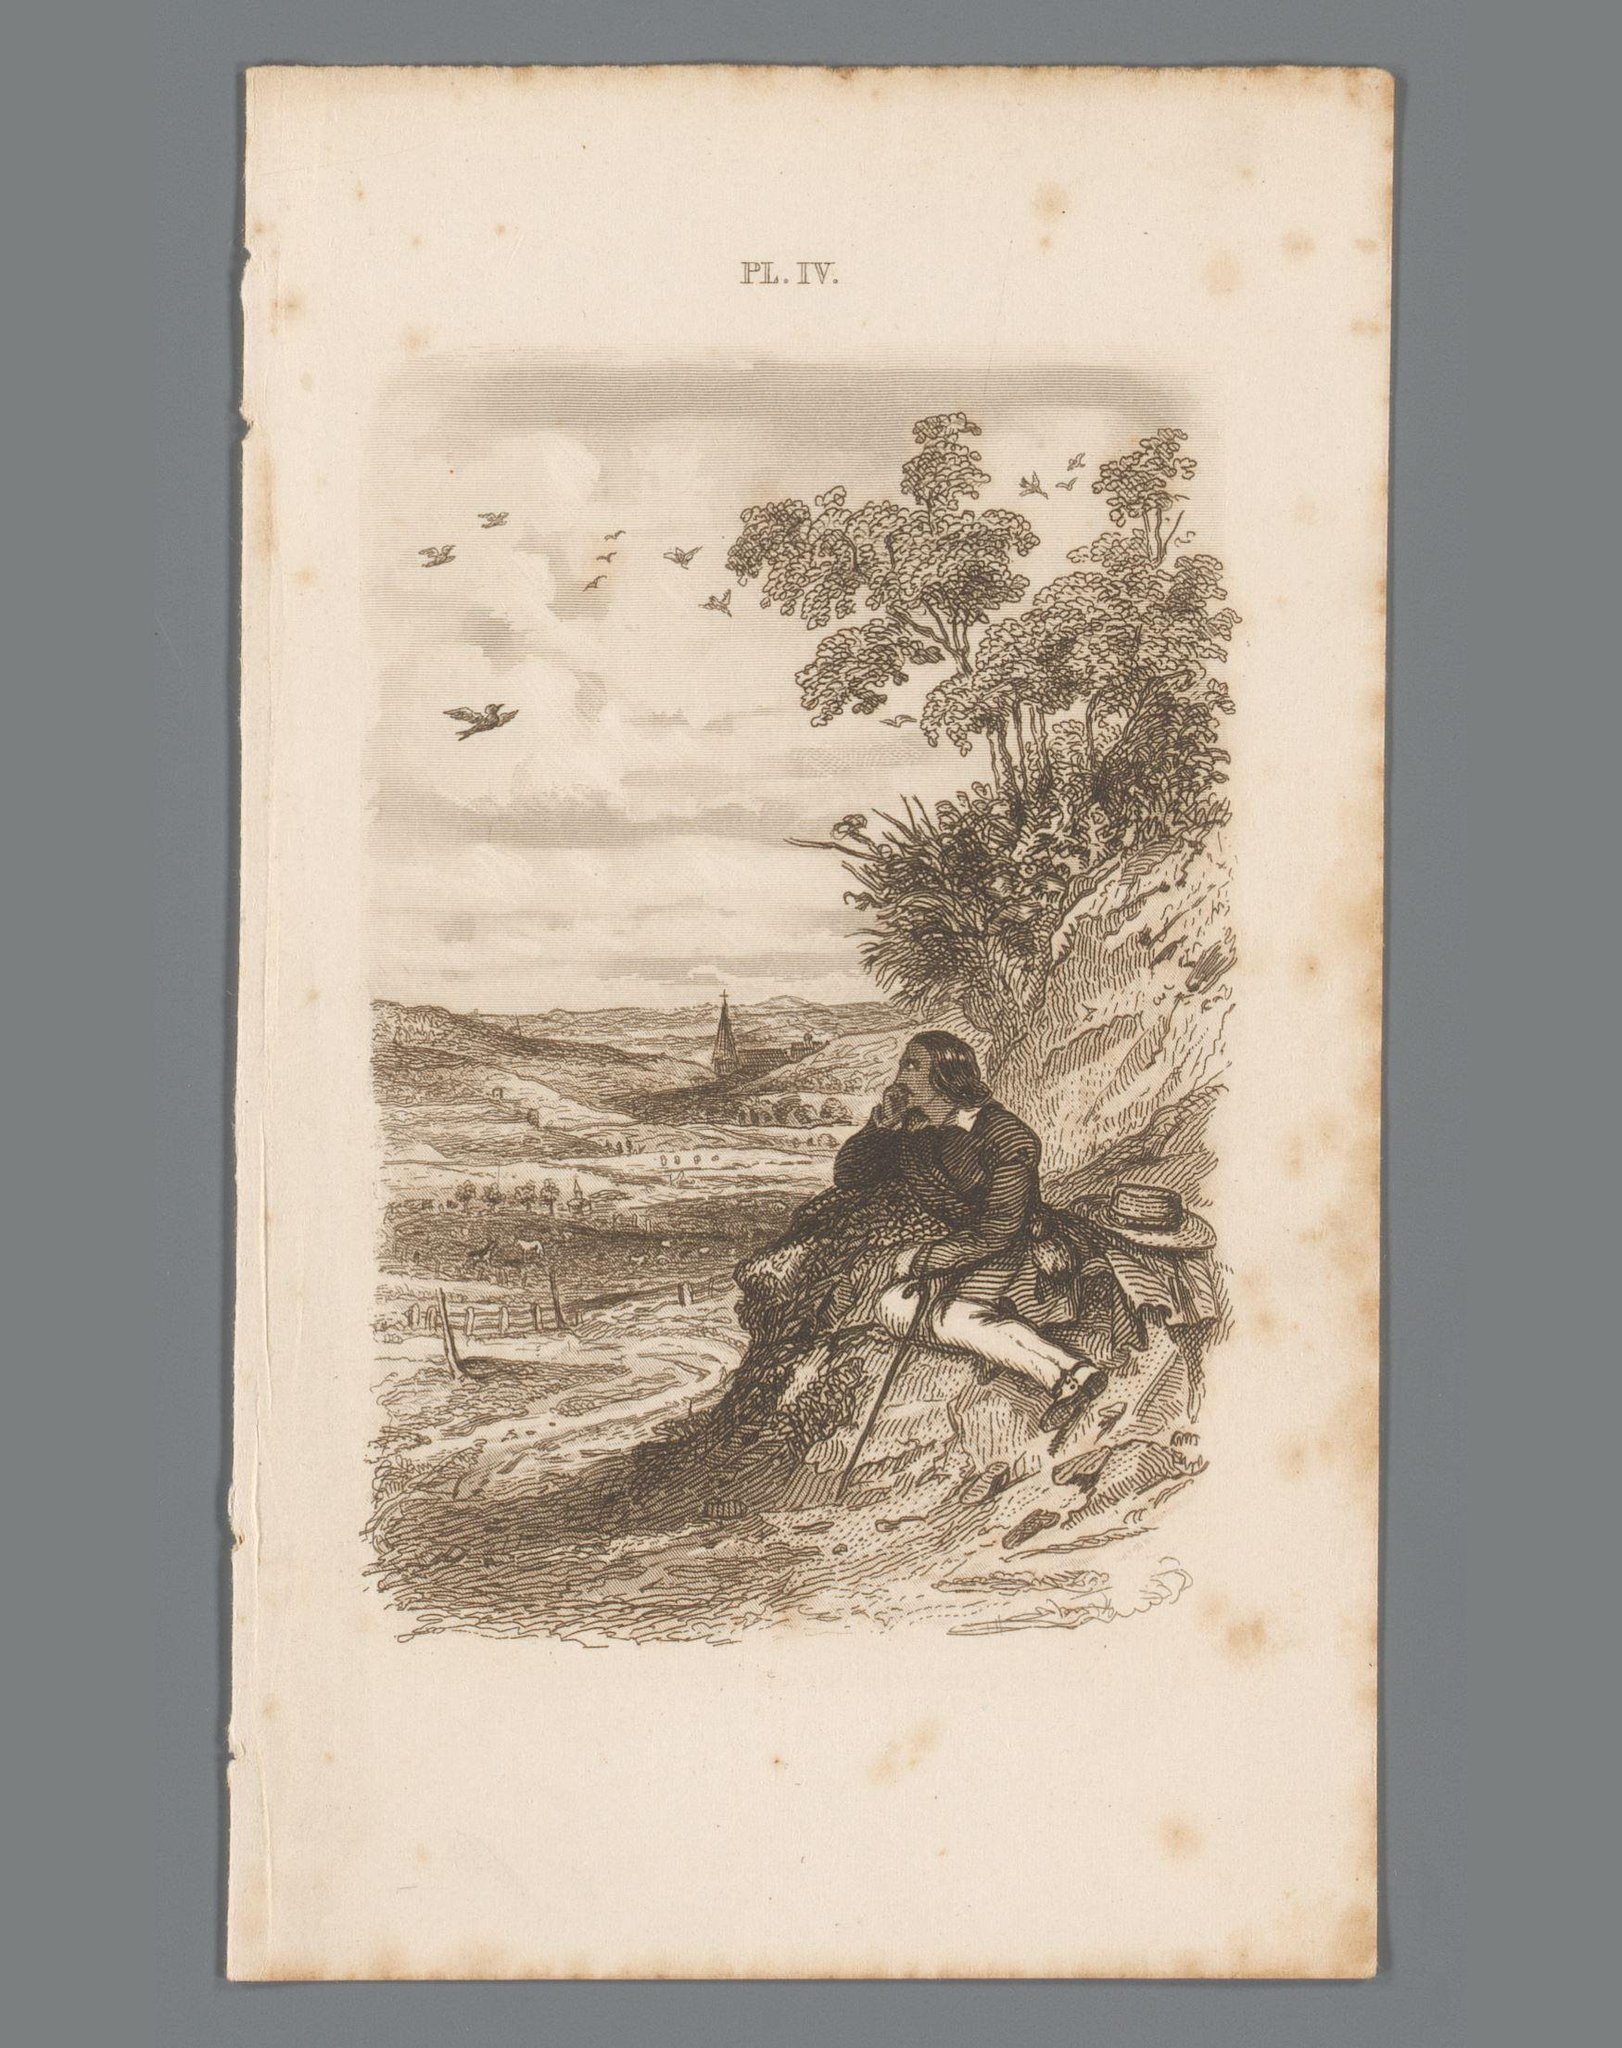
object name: book illustration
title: De velden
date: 1856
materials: paper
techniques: engraving, etching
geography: schoonhoven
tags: (traveller) resting in the open air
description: Prent uit: Koetsveld, C.E. van. De portefeuille met platen van grootvader Sprankhof. Schoonhoven: S.E. van Nooten, 1856, na p. 102.